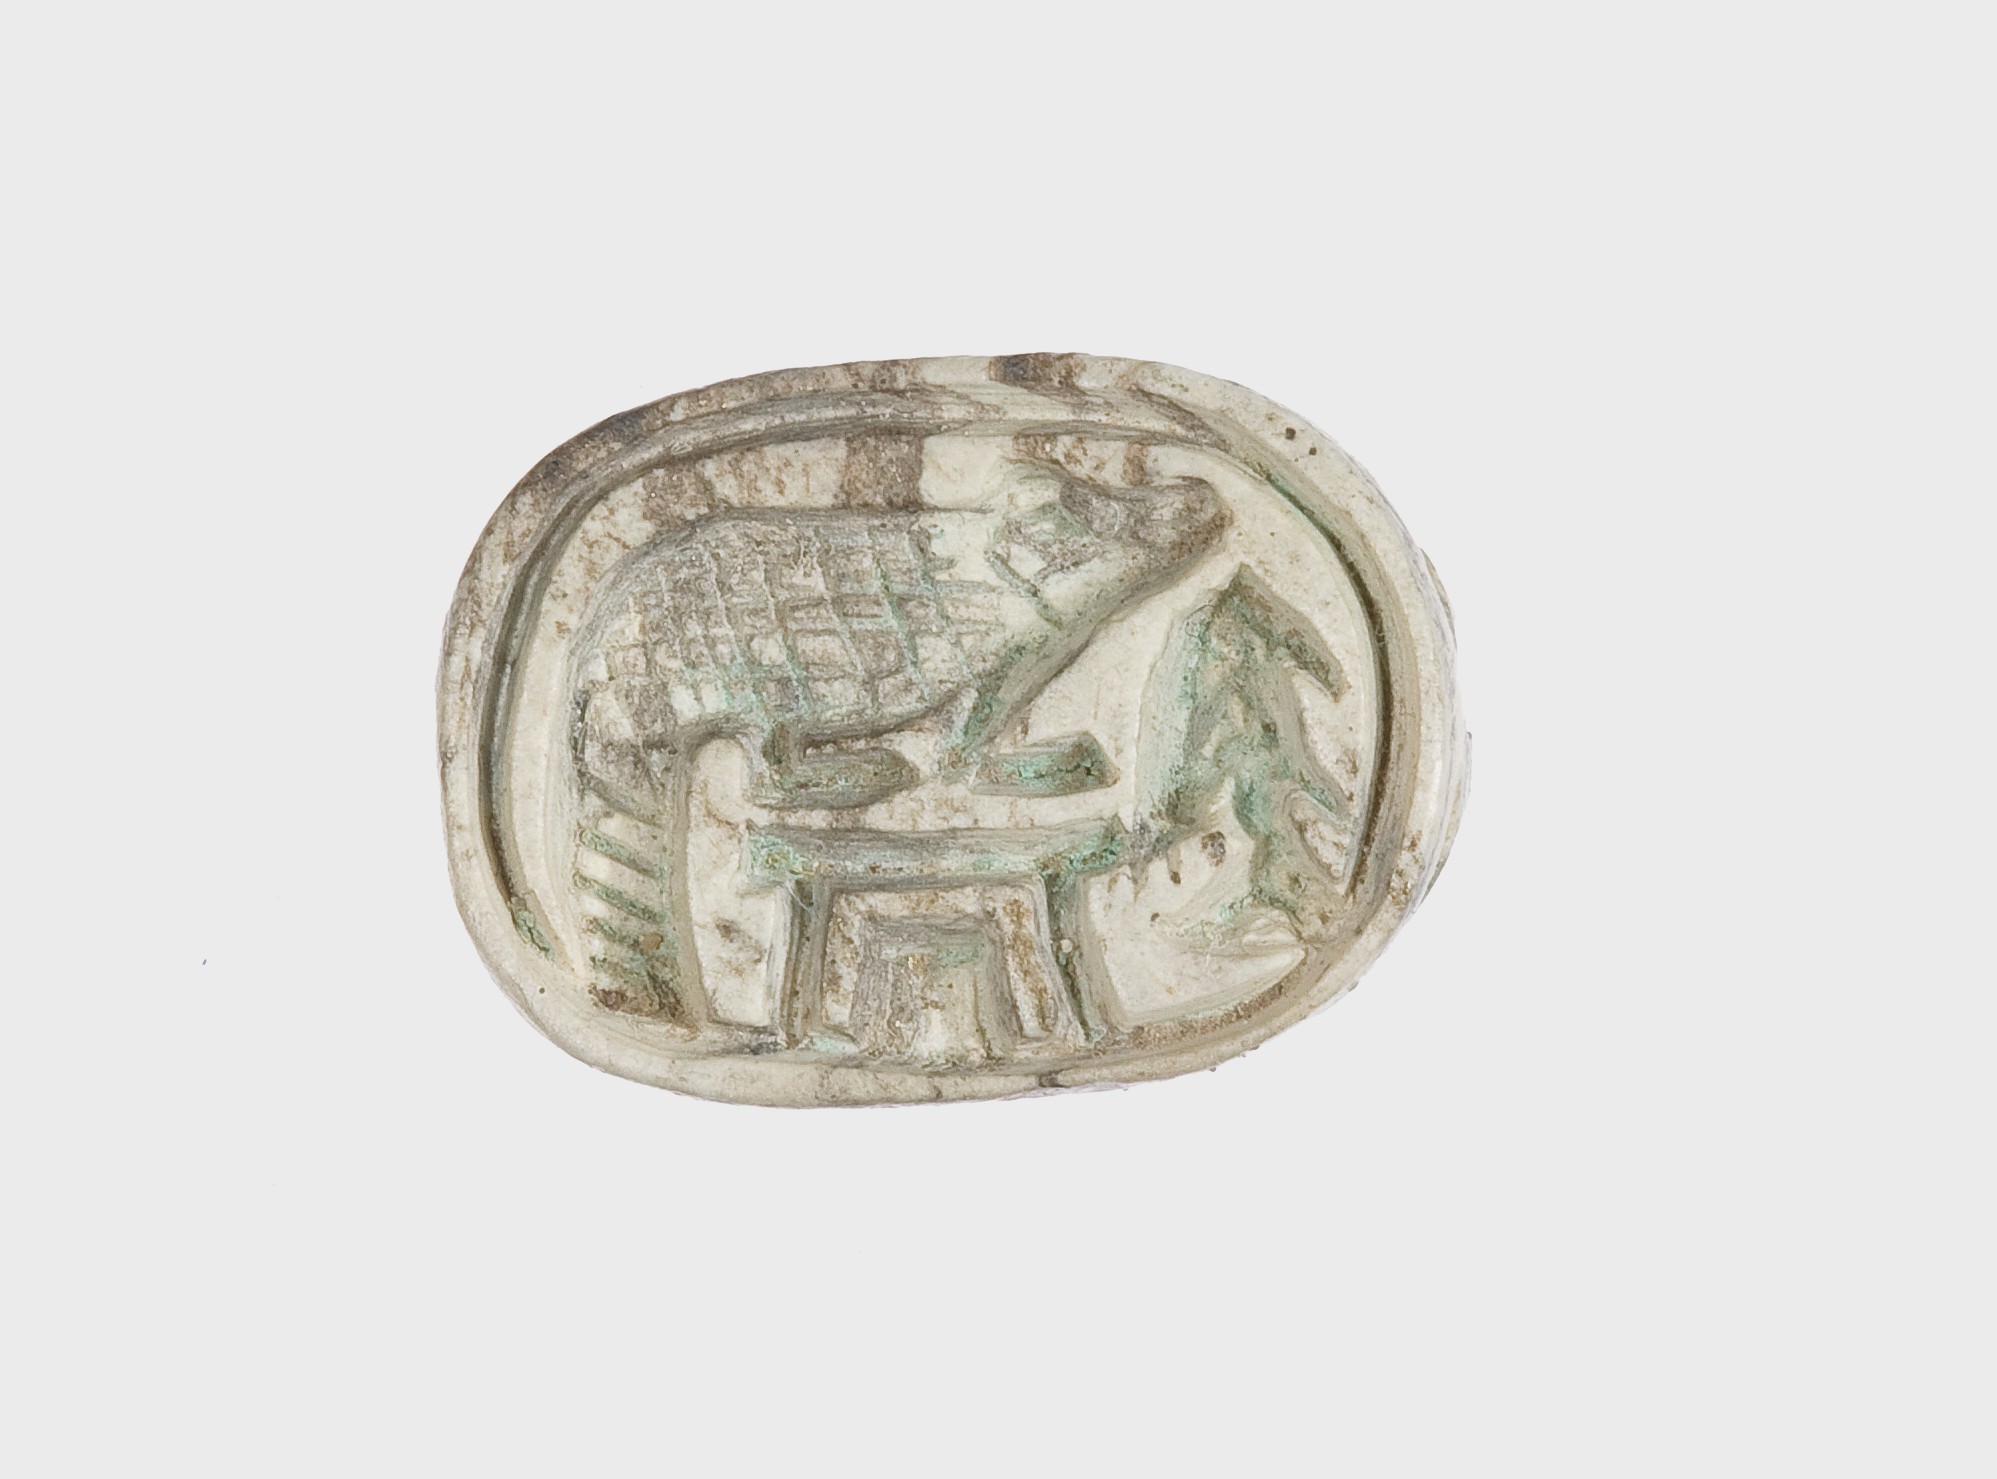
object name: scarab, sobek crocodile, fish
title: Scarab Inscribed with the Sobek Crocodile and a Fish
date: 1390-1352 BCE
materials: mica, stone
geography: egypt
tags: crocodiles,fish,scarabs